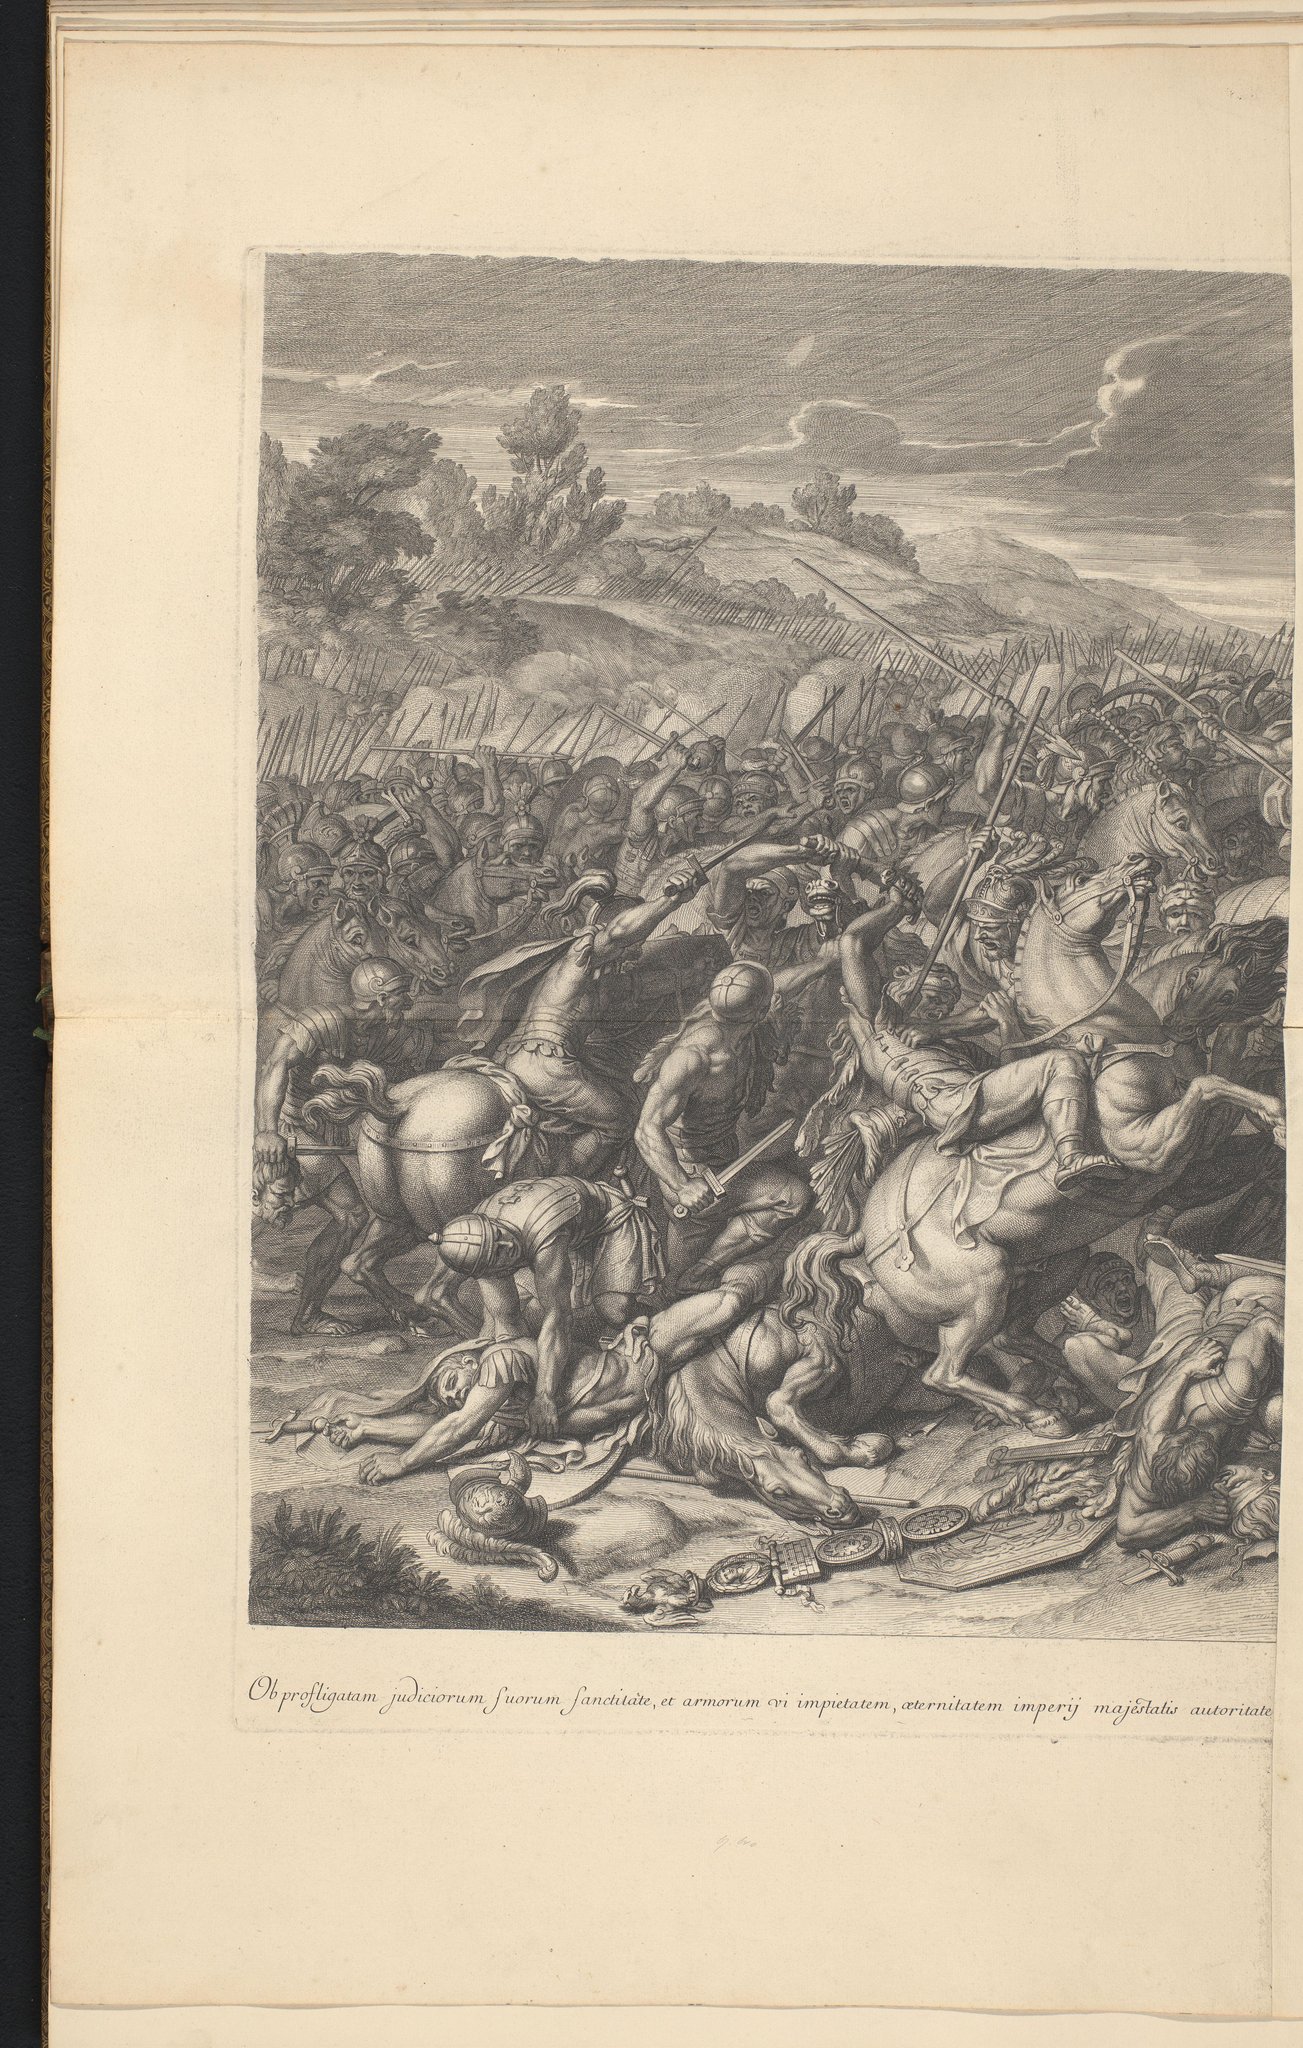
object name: print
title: Slag van Constantijn tegen Maxentius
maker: gérard audran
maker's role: print maker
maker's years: 1640-1703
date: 1666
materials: paper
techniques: engraving, etching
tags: the battle of the milvian bridge (saxa rubra): st. constantine on horseback confronts maxentius; a cross appears in the sky with in fiery letters 'in hoc signo vinces' (the raised standards of the roman soldiers carry a cross or the chi-rho monogram), rome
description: Linker deel van een prent gedrukt van drie platen.